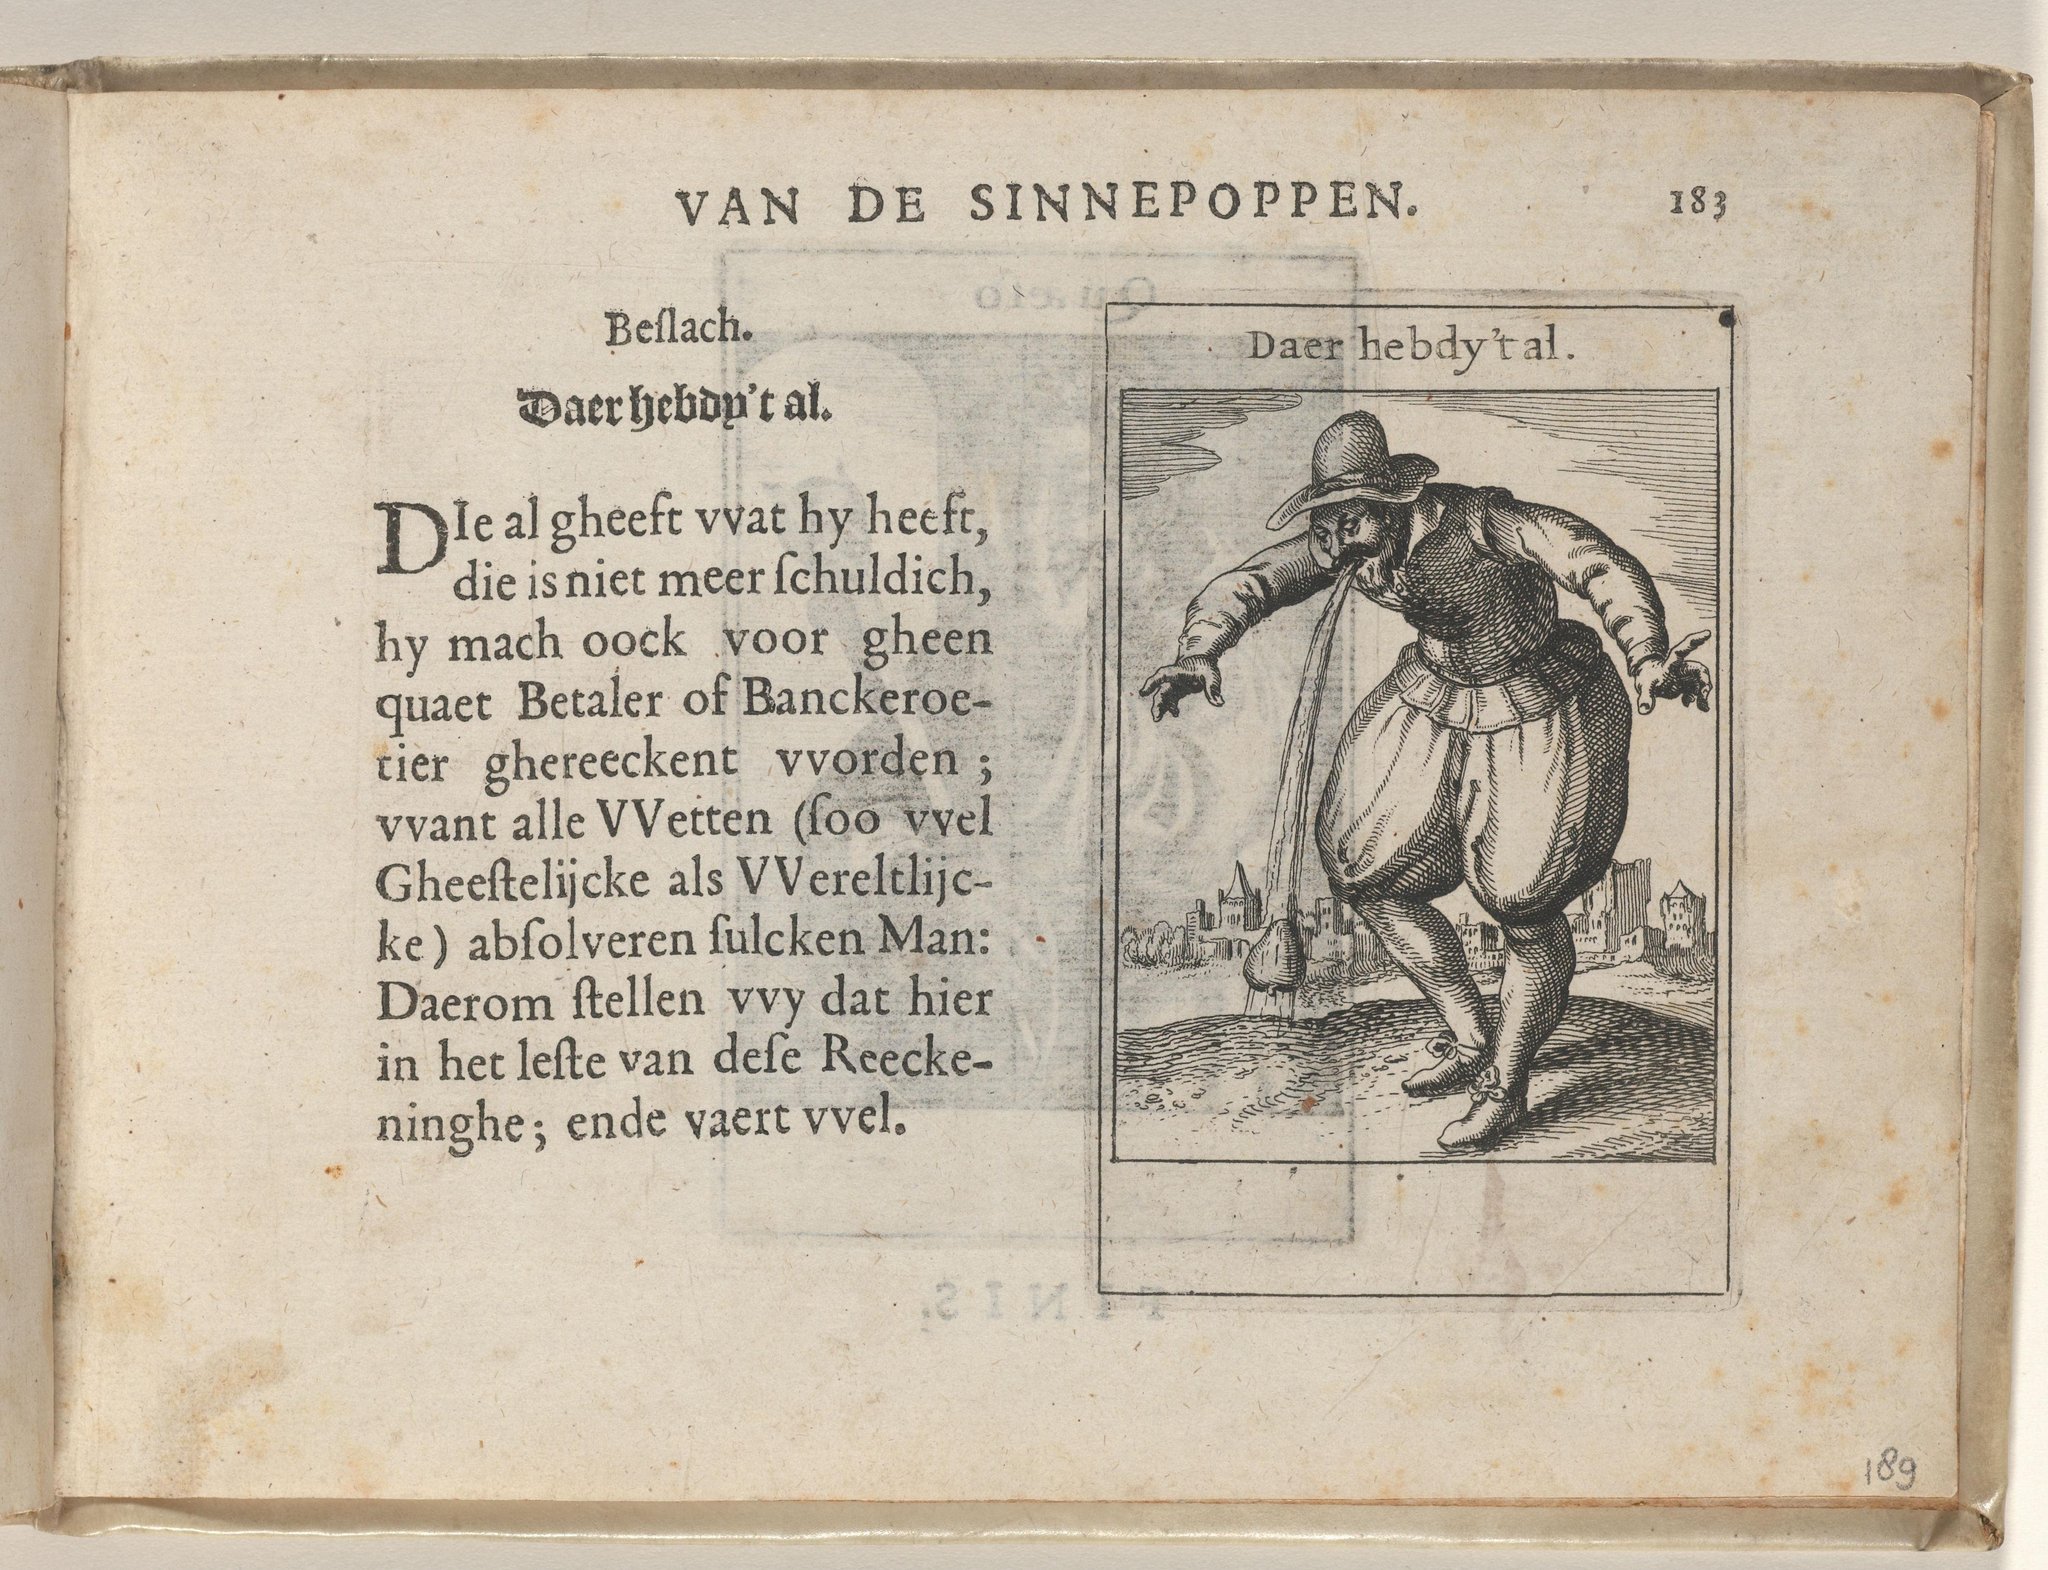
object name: album leaf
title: Beslach Daer hebdy't al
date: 1614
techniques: engraving, printing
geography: amsterdam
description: Beslach Daer hebdy't al. Derde schok. Onderdeel van 'Sinnepoppen', R. Visscher, 1614.